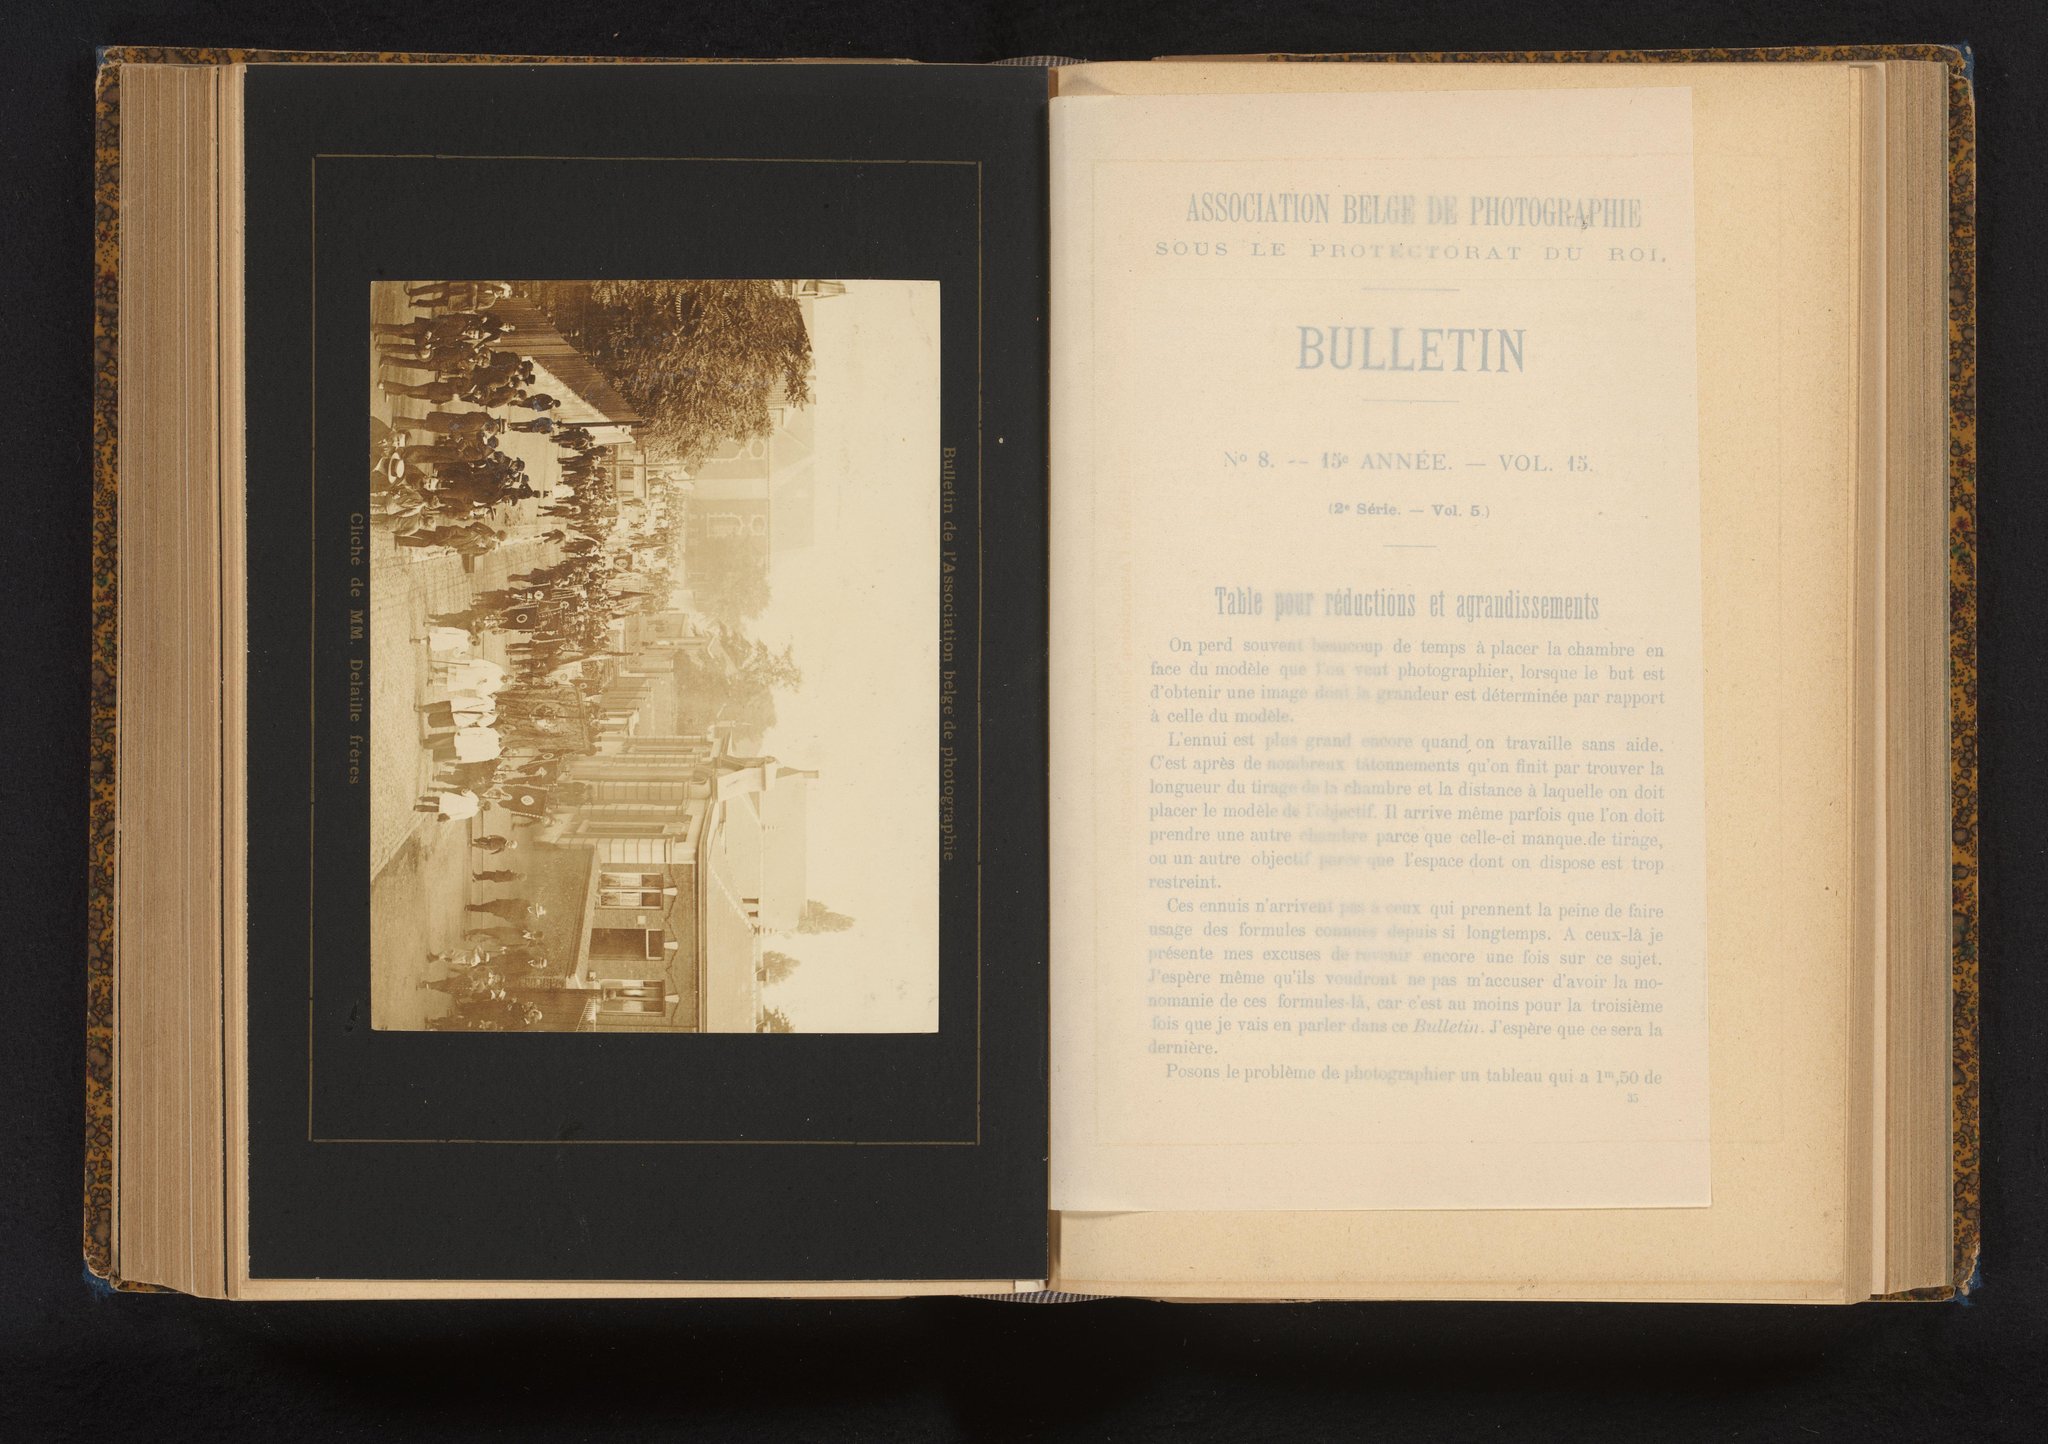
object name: photograph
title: Religieuze processie te Luik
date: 1885-1888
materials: paper, cardboard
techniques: chlorobromide paper print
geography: liège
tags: procession ~ christian religion, street, liège